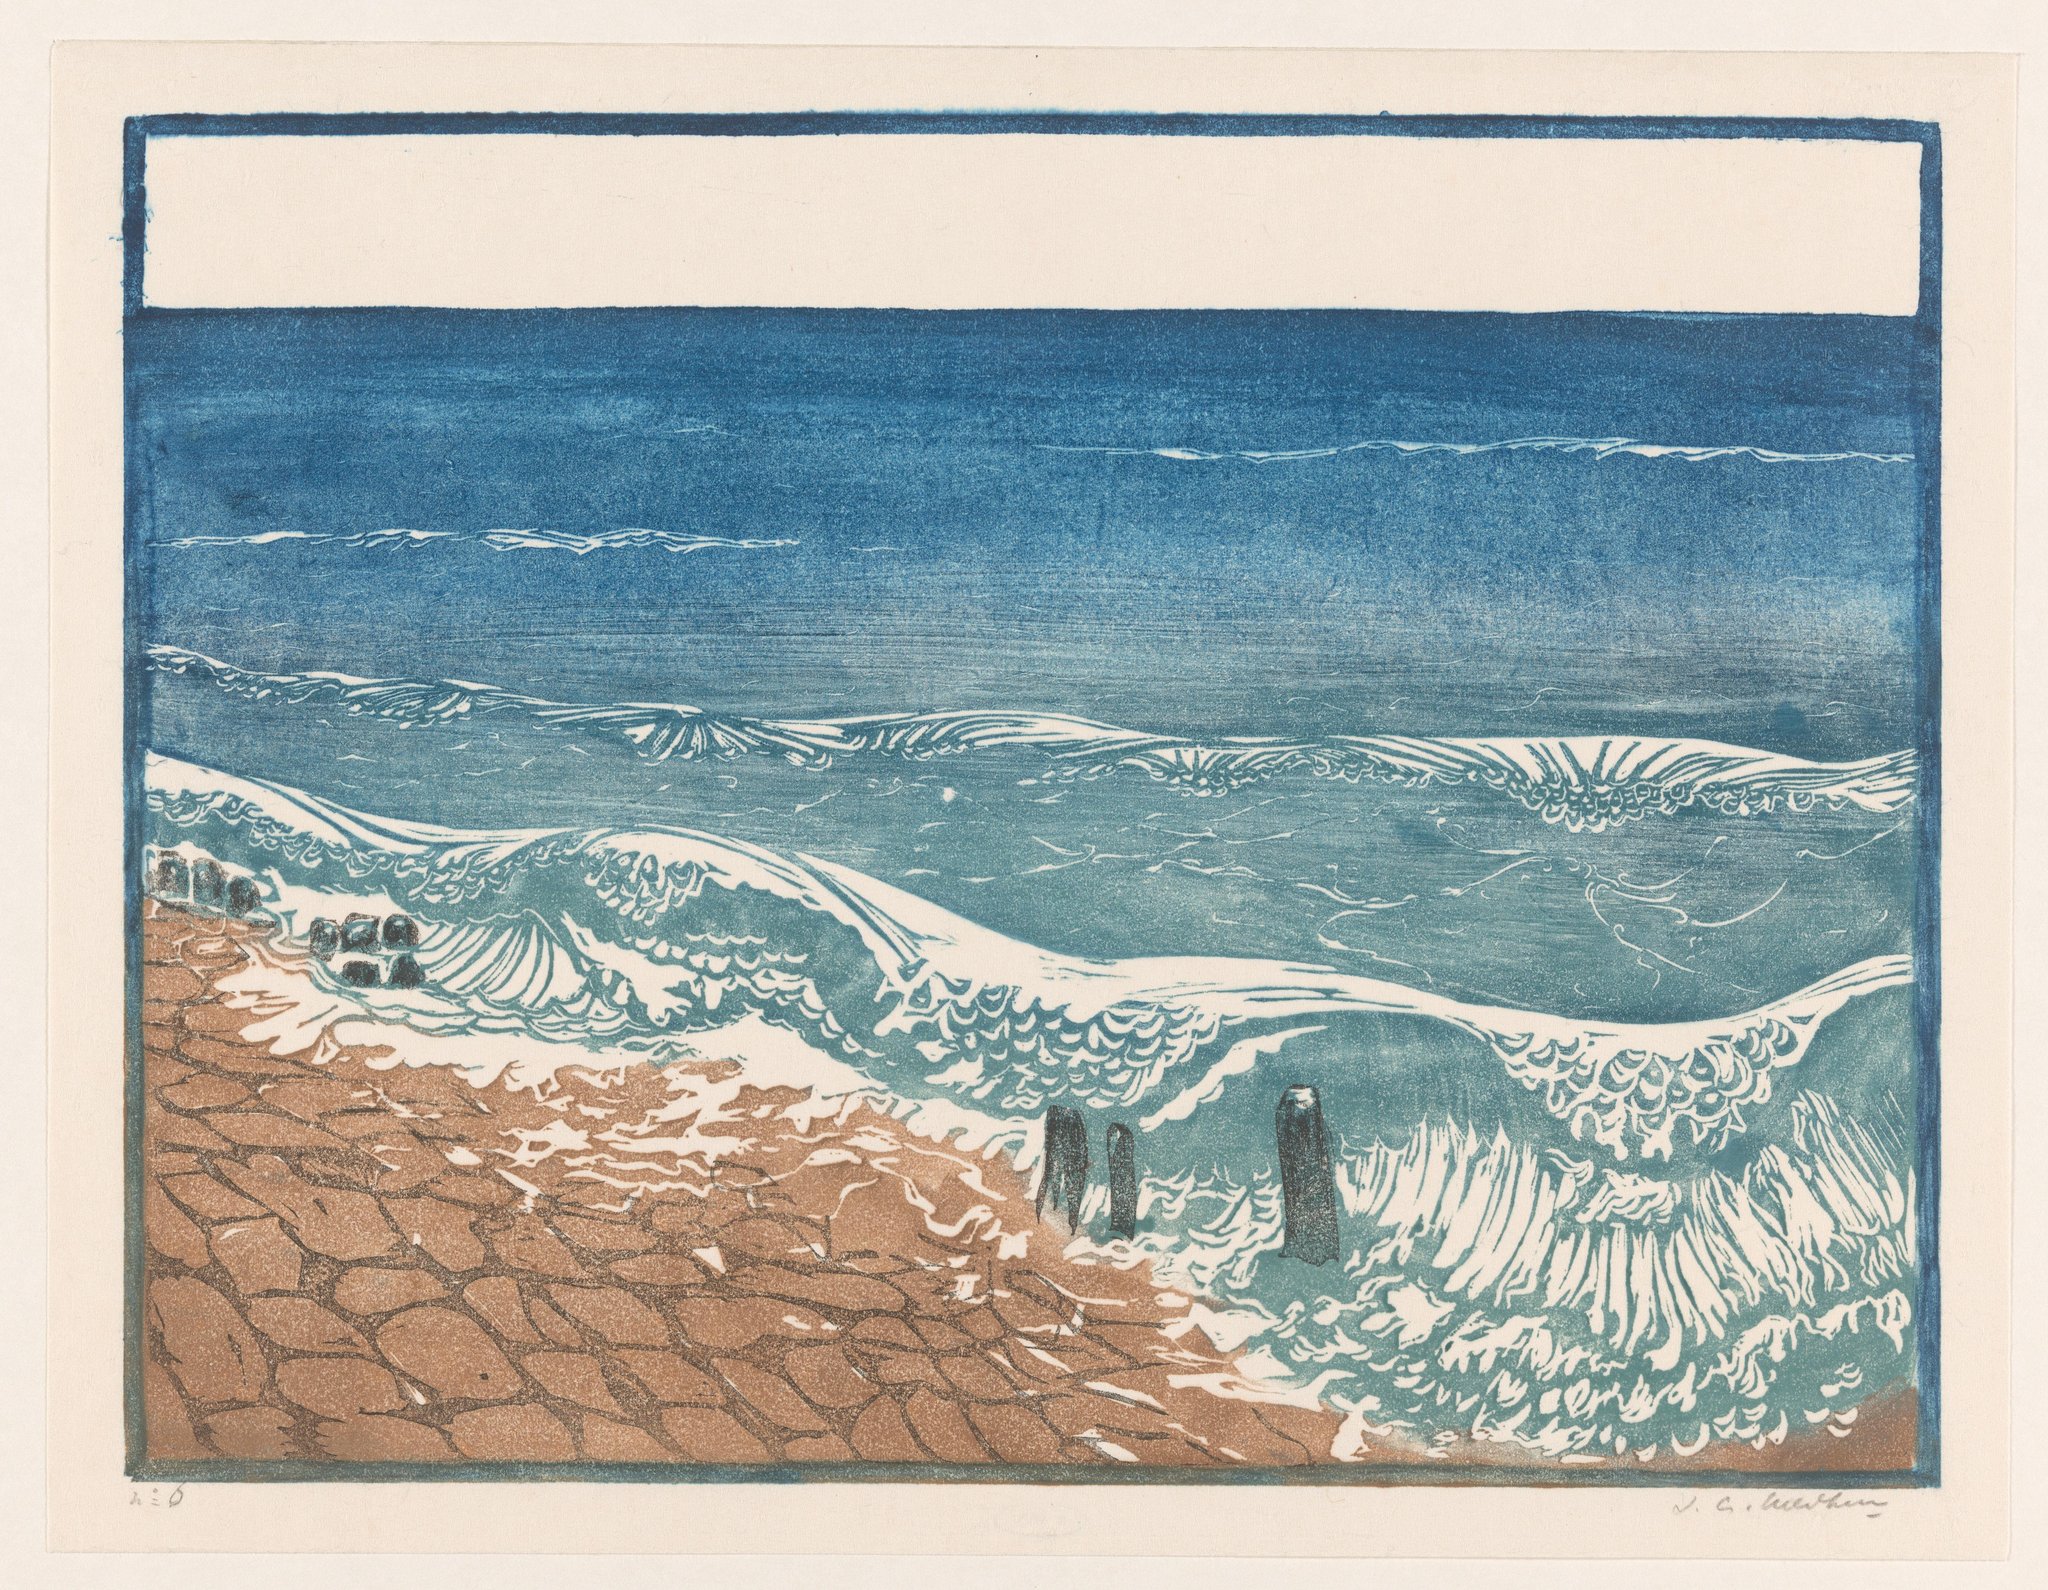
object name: print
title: Meerpalen in de branding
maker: jacobus gerardus veldheer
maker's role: draughtsman, print maker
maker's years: 1866-1954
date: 1876-1916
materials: paper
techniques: woodcut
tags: mooring-buoy, bollard, surf, breakers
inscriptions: collector's mark: Lugt 2760, collector's mark: Lugt 2228